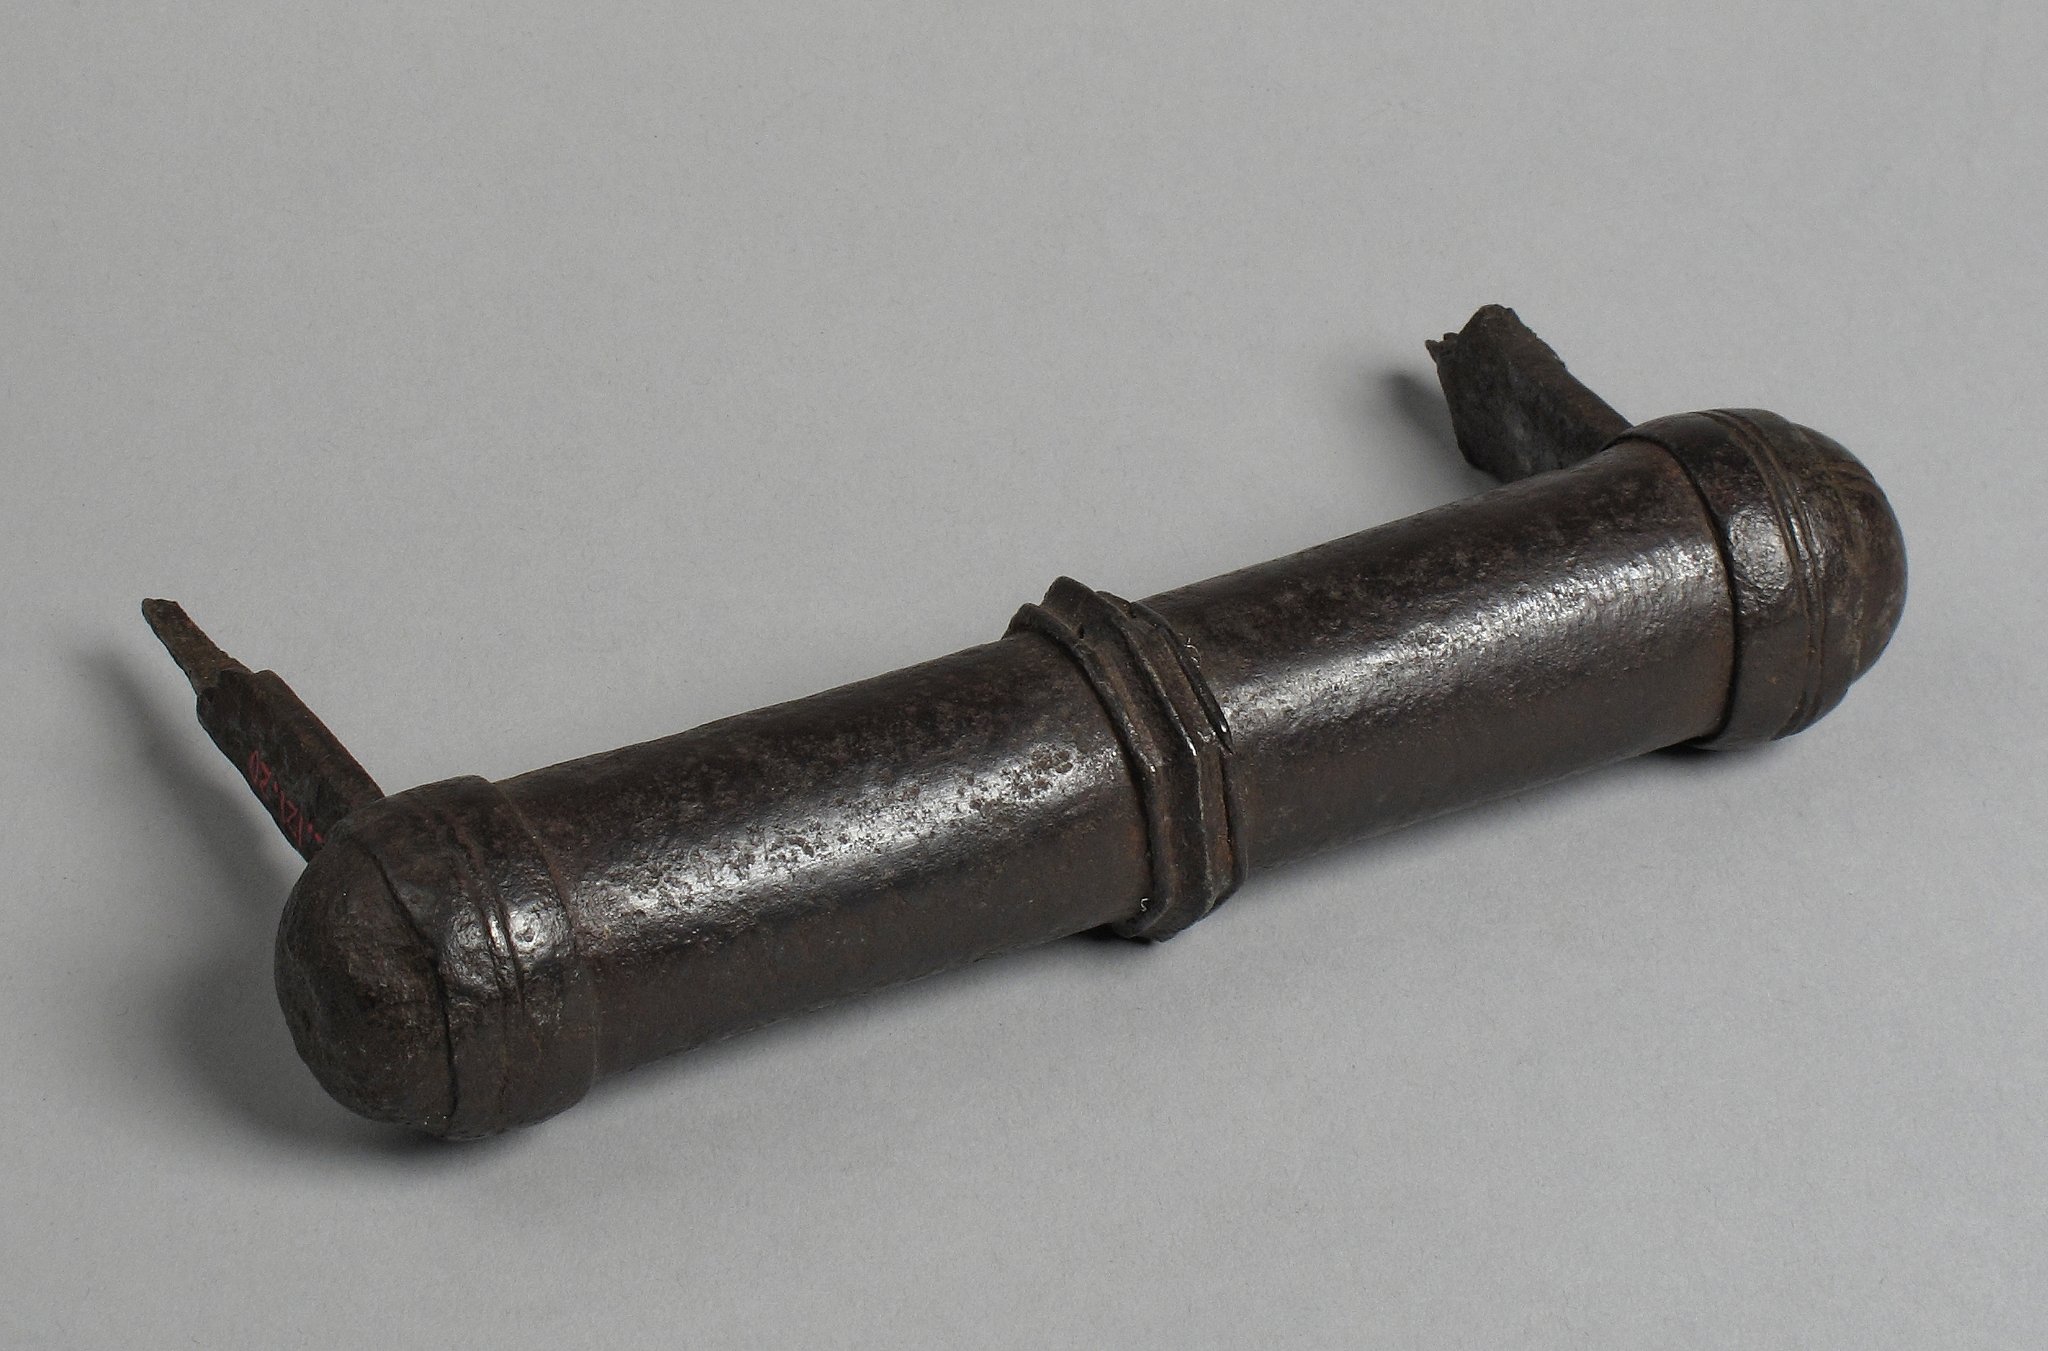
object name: door pull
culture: european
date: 1401-1600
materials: iron